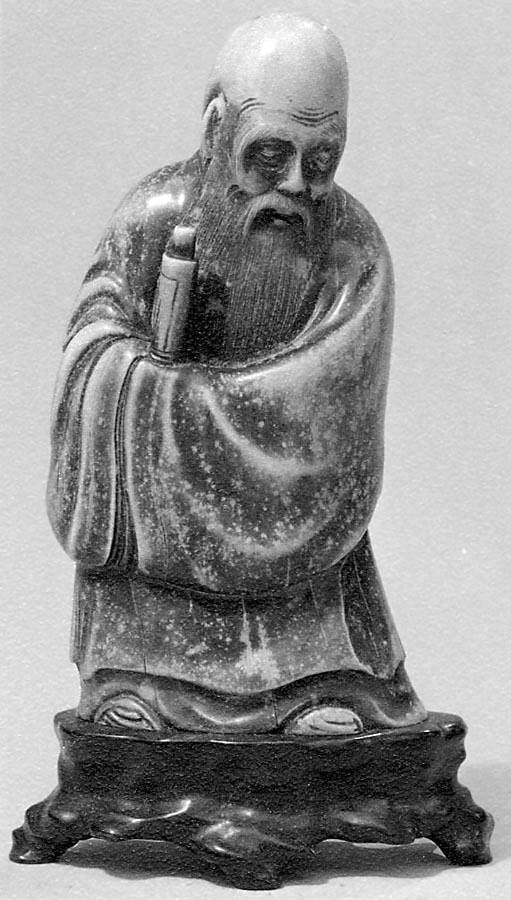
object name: statuette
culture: chinese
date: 1767-1800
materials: ivory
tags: men